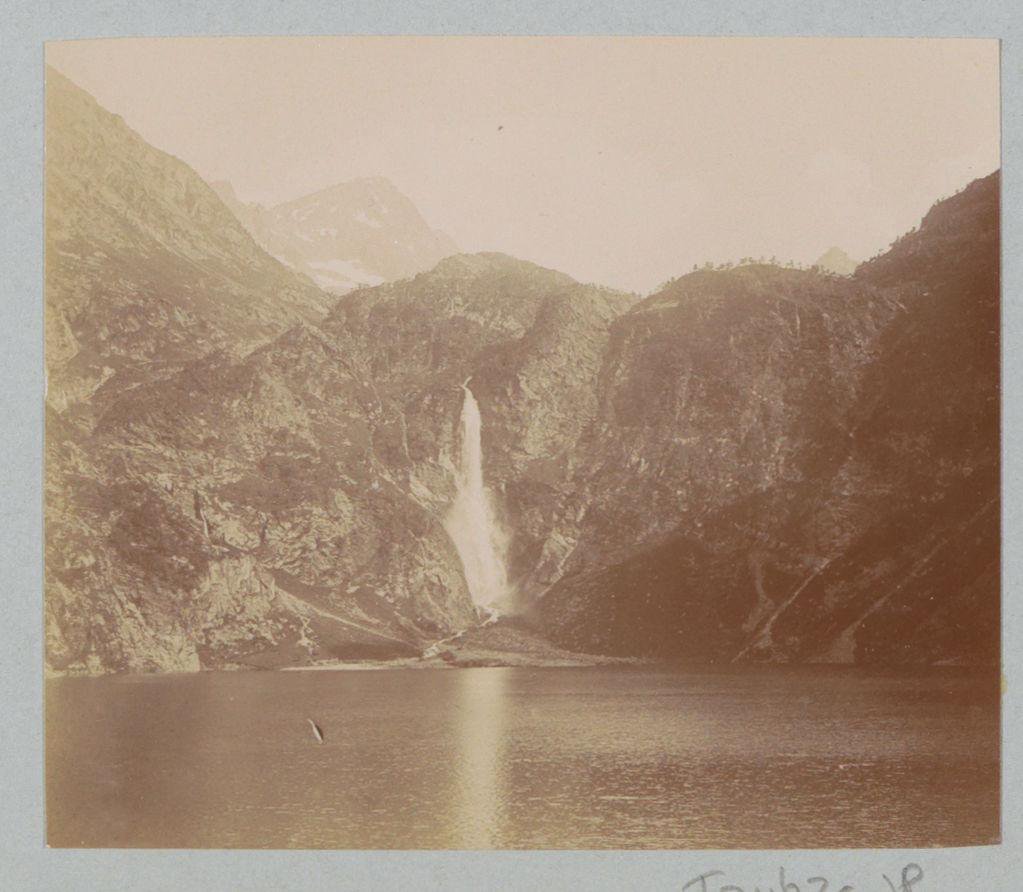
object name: photograph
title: Gezicht op een bergwand met een waterval en een meer, vermoedelijk in de Pyreneeën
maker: Anonymous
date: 1905-1910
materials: paper, photographic support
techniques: gelatin silver print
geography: pyrenees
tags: waterfall, lake, mountains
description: Onderdeel van Fotoalbum van een Franse amateurfotograaf met bezienswaardigheden in Frankrijk, Zwitserland en Italië.